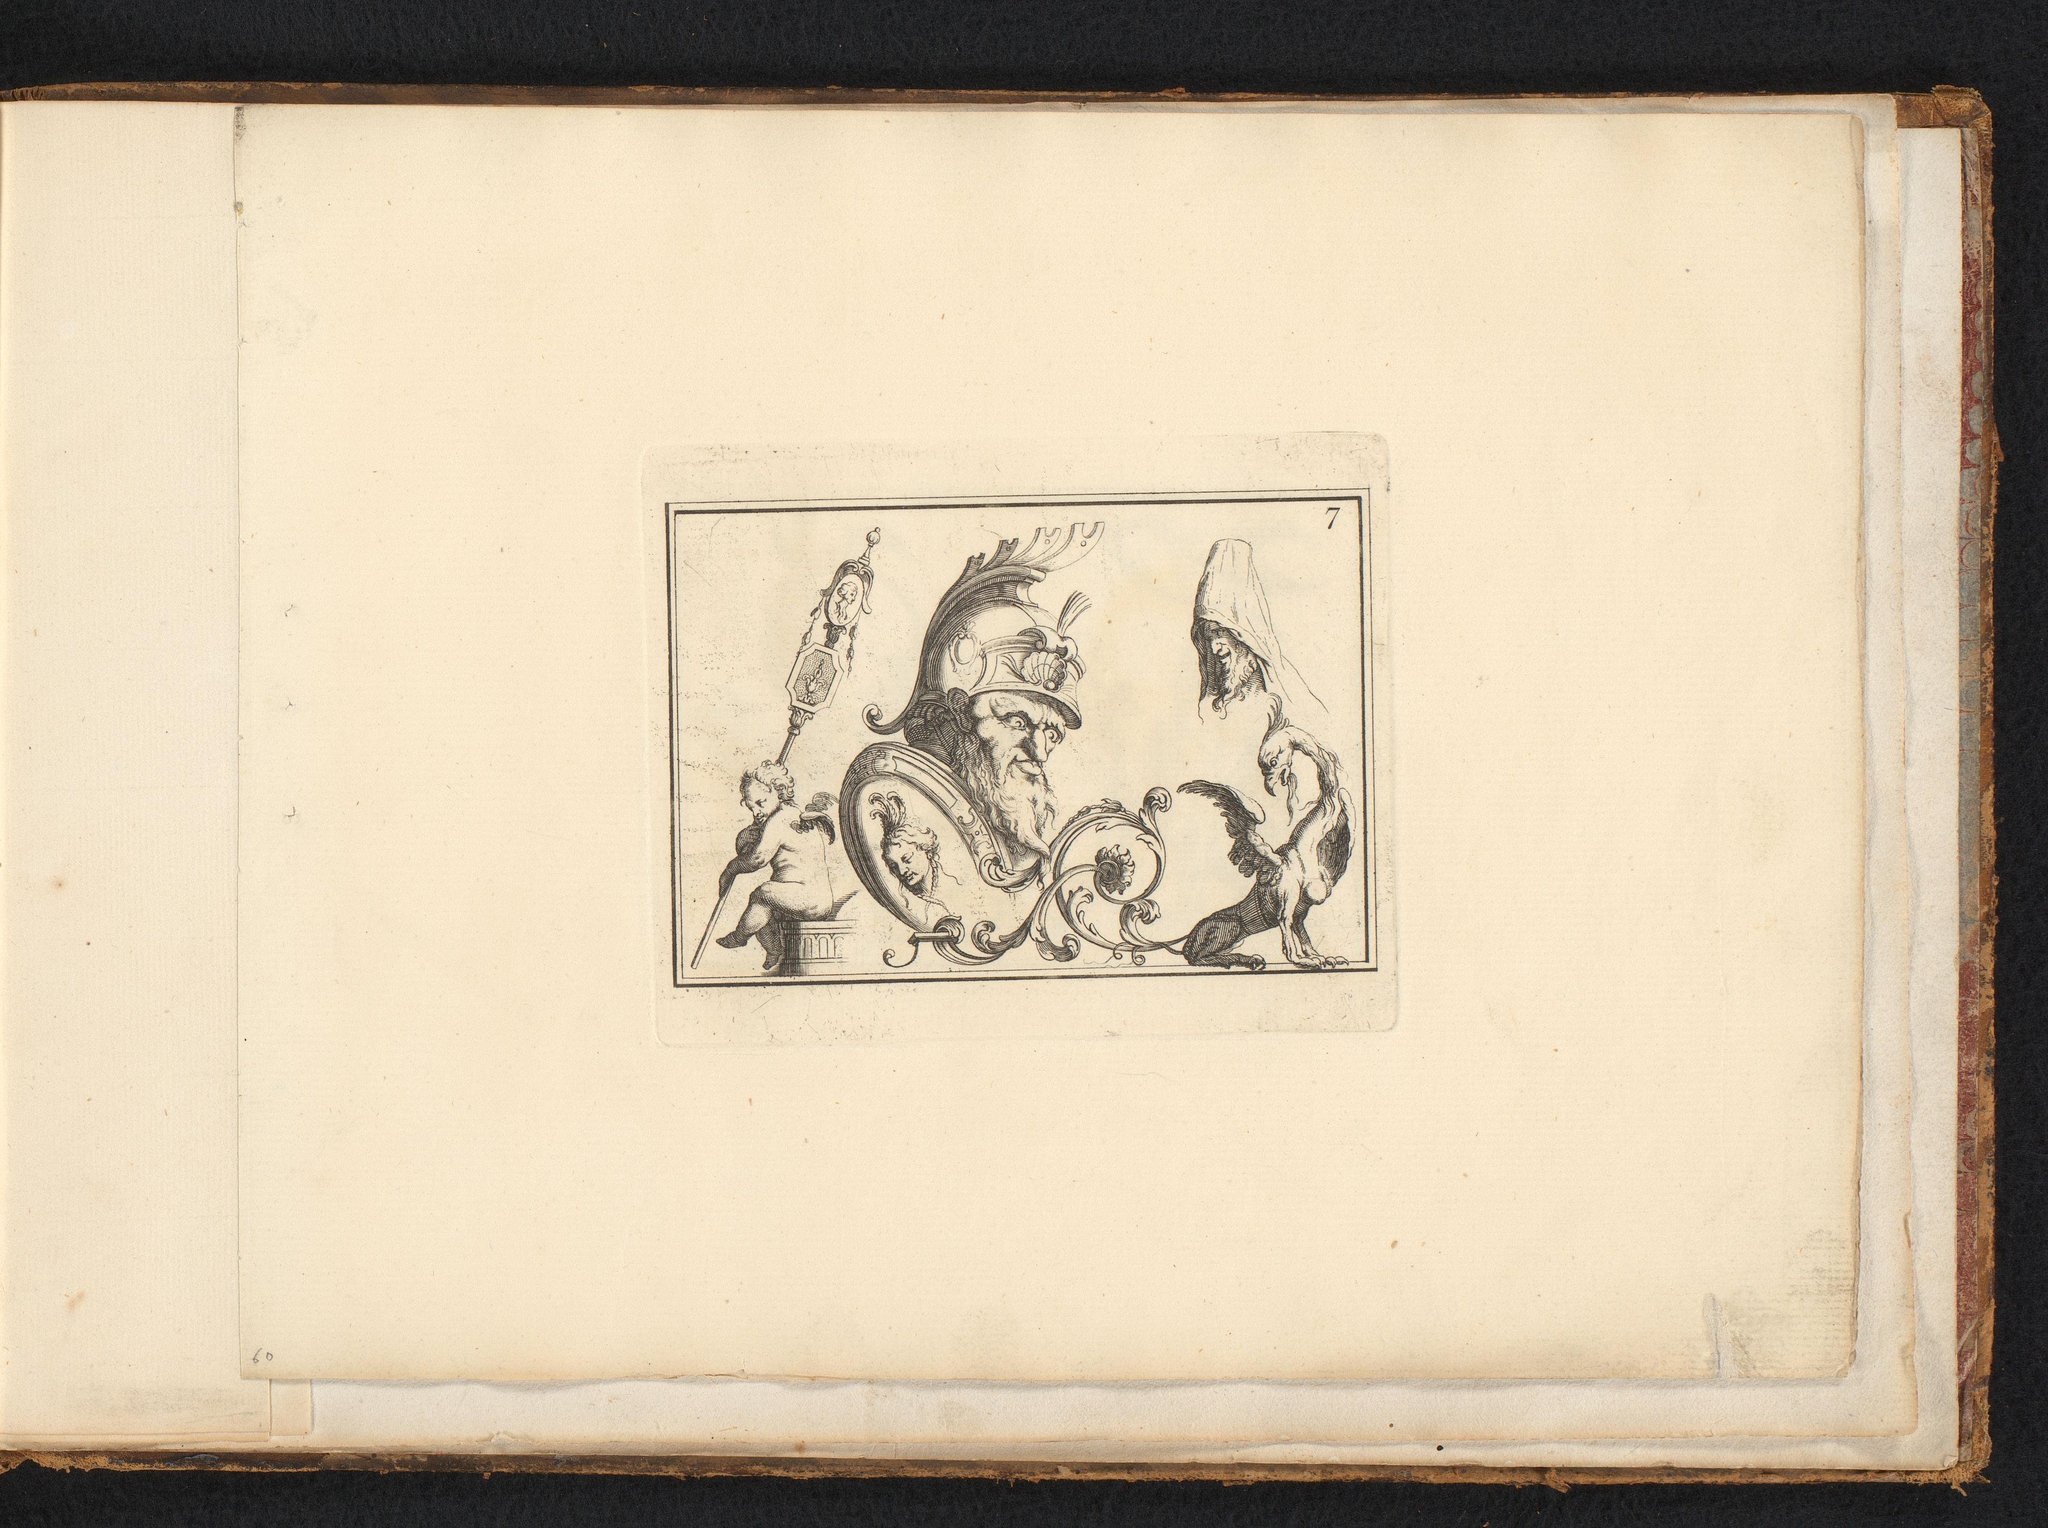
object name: ornament print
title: Ontwerpen voor maskers en andere ornamenten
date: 1745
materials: paper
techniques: etching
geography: london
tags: fabulous animals (sometimes wrongly called 'grotesques'); 'mostri' (ripa), mask, mascaron ~ ornament, cupids: 'amores', 'amoretti', 'putti'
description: Rechtsboven genummerd: 7. Prent maakt deel uit van een album.